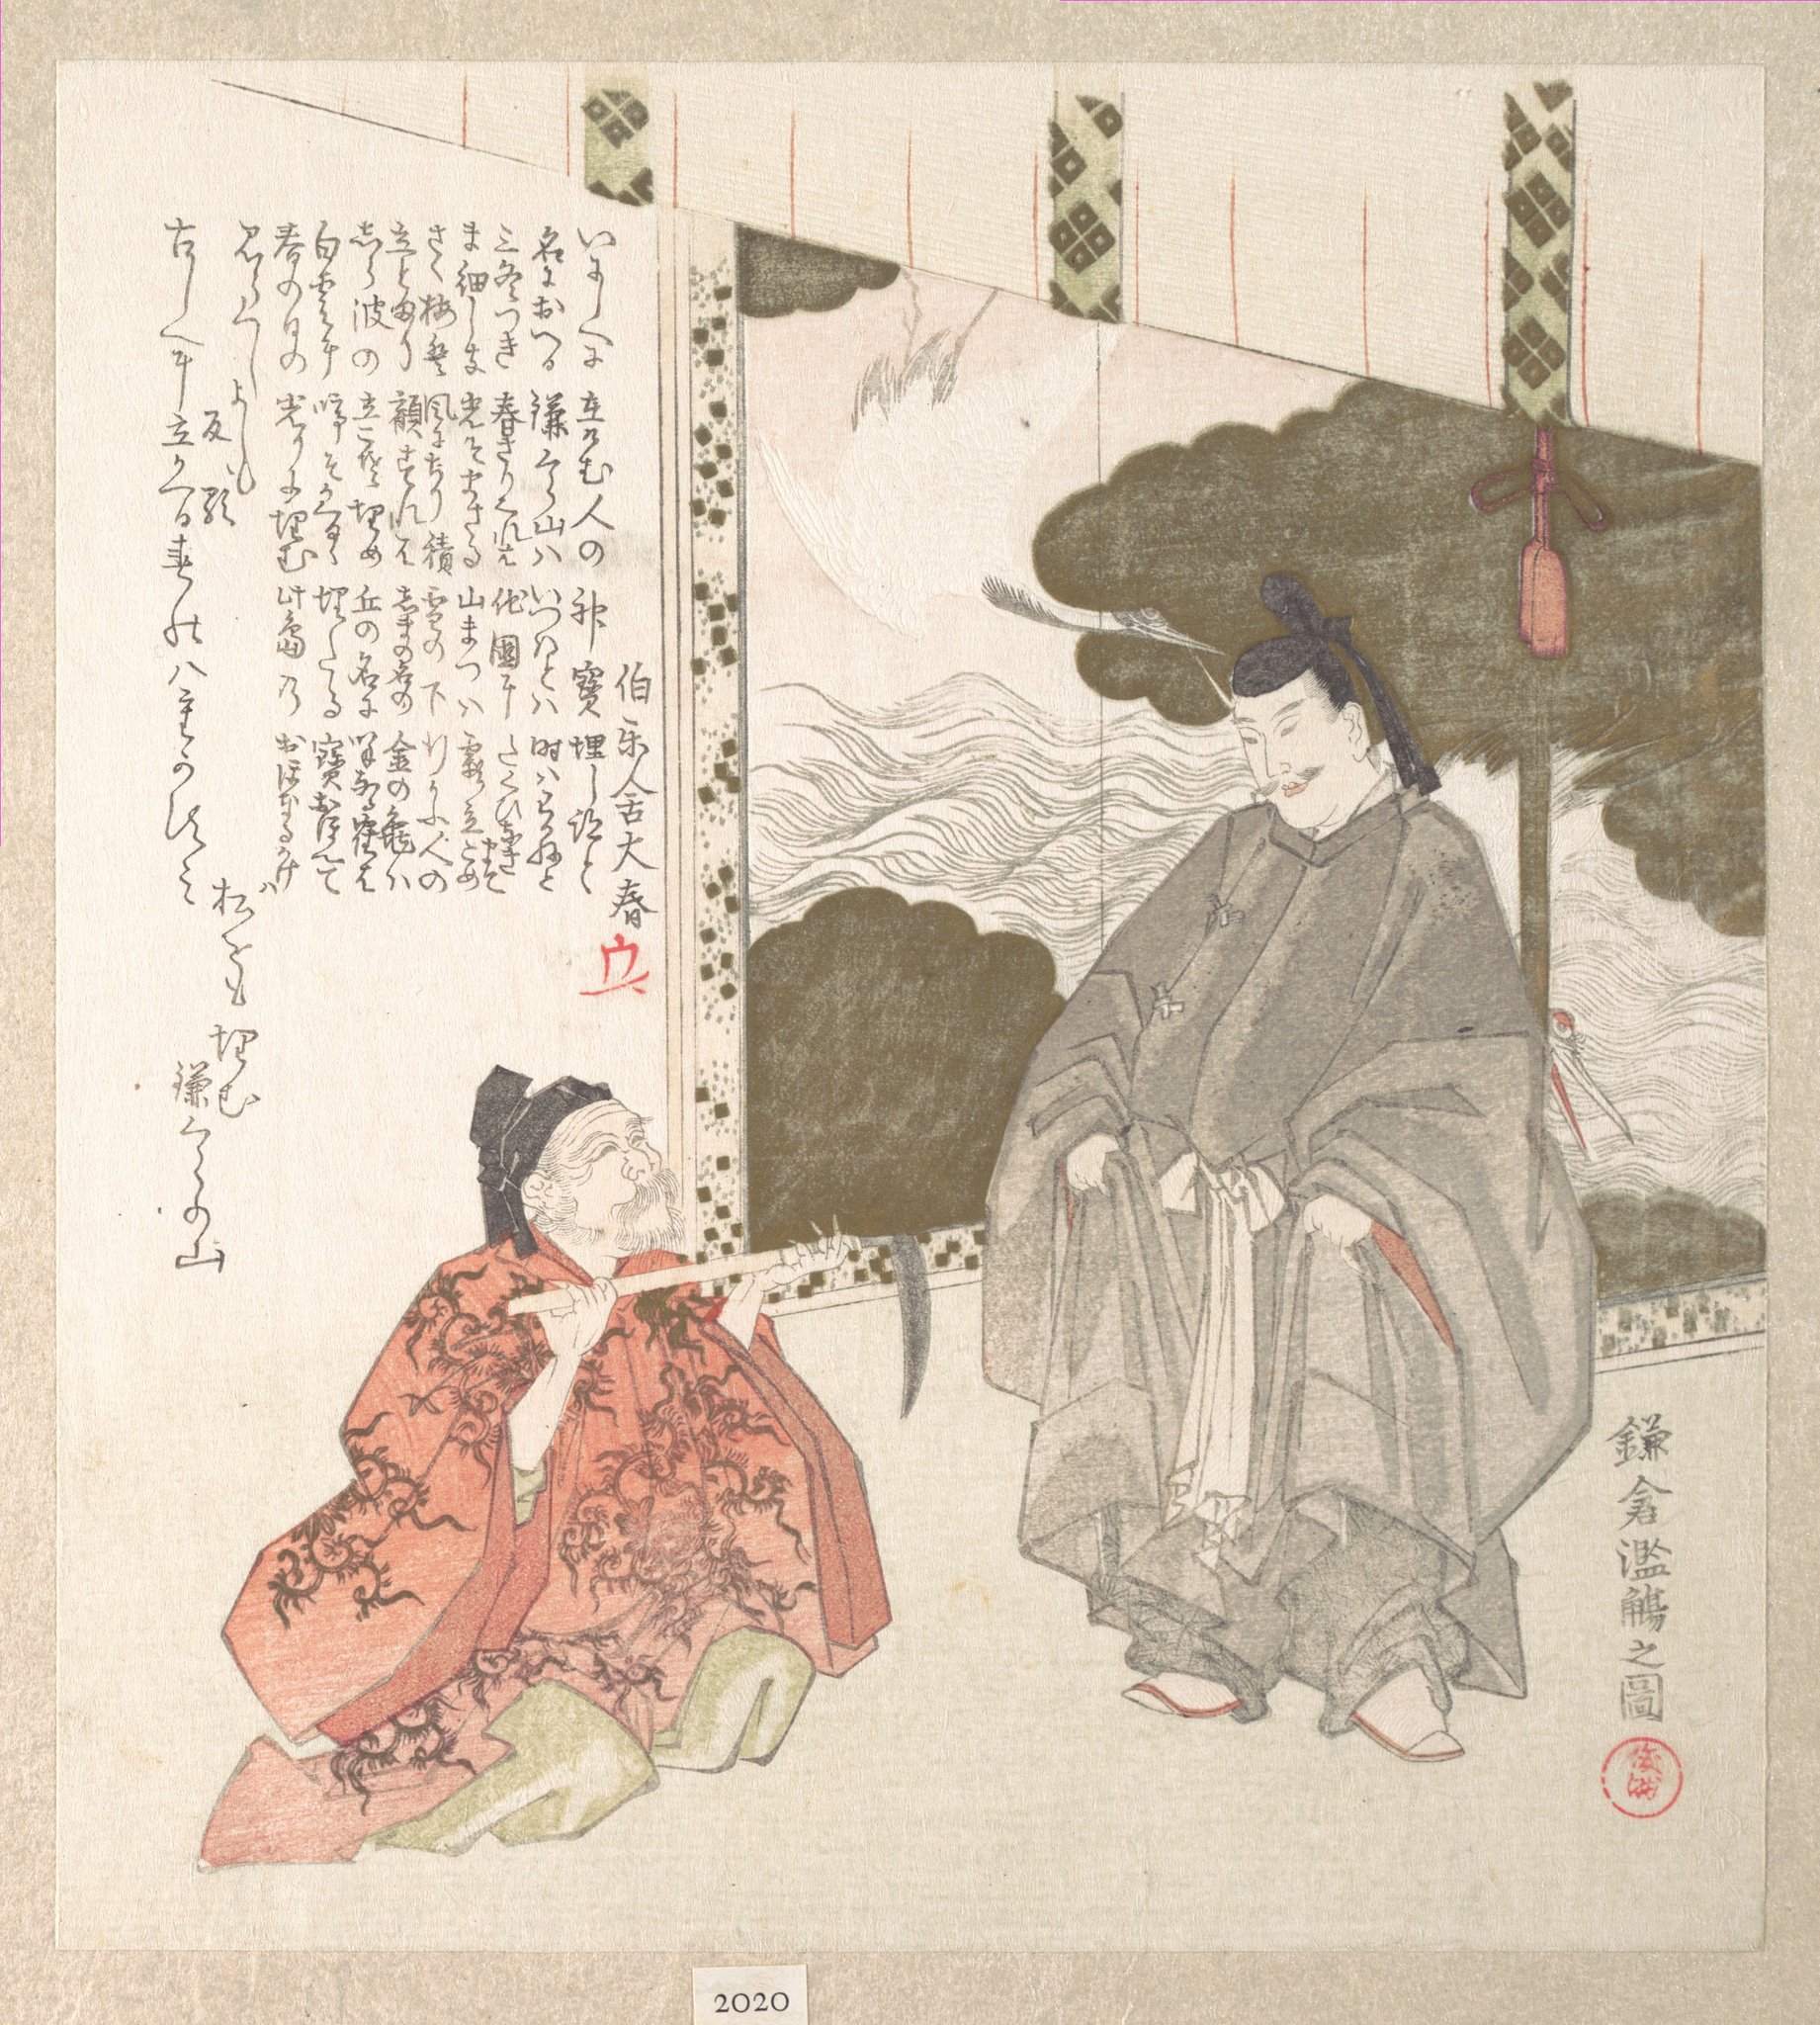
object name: print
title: History of Kamakura (where Minamoto Shogunate was Established)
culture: japanese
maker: kubo shunman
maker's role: artist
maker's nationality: japanese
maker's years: 1757-1820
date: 1801-1900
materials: ink, paper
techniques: surimono, woodblock print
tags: men